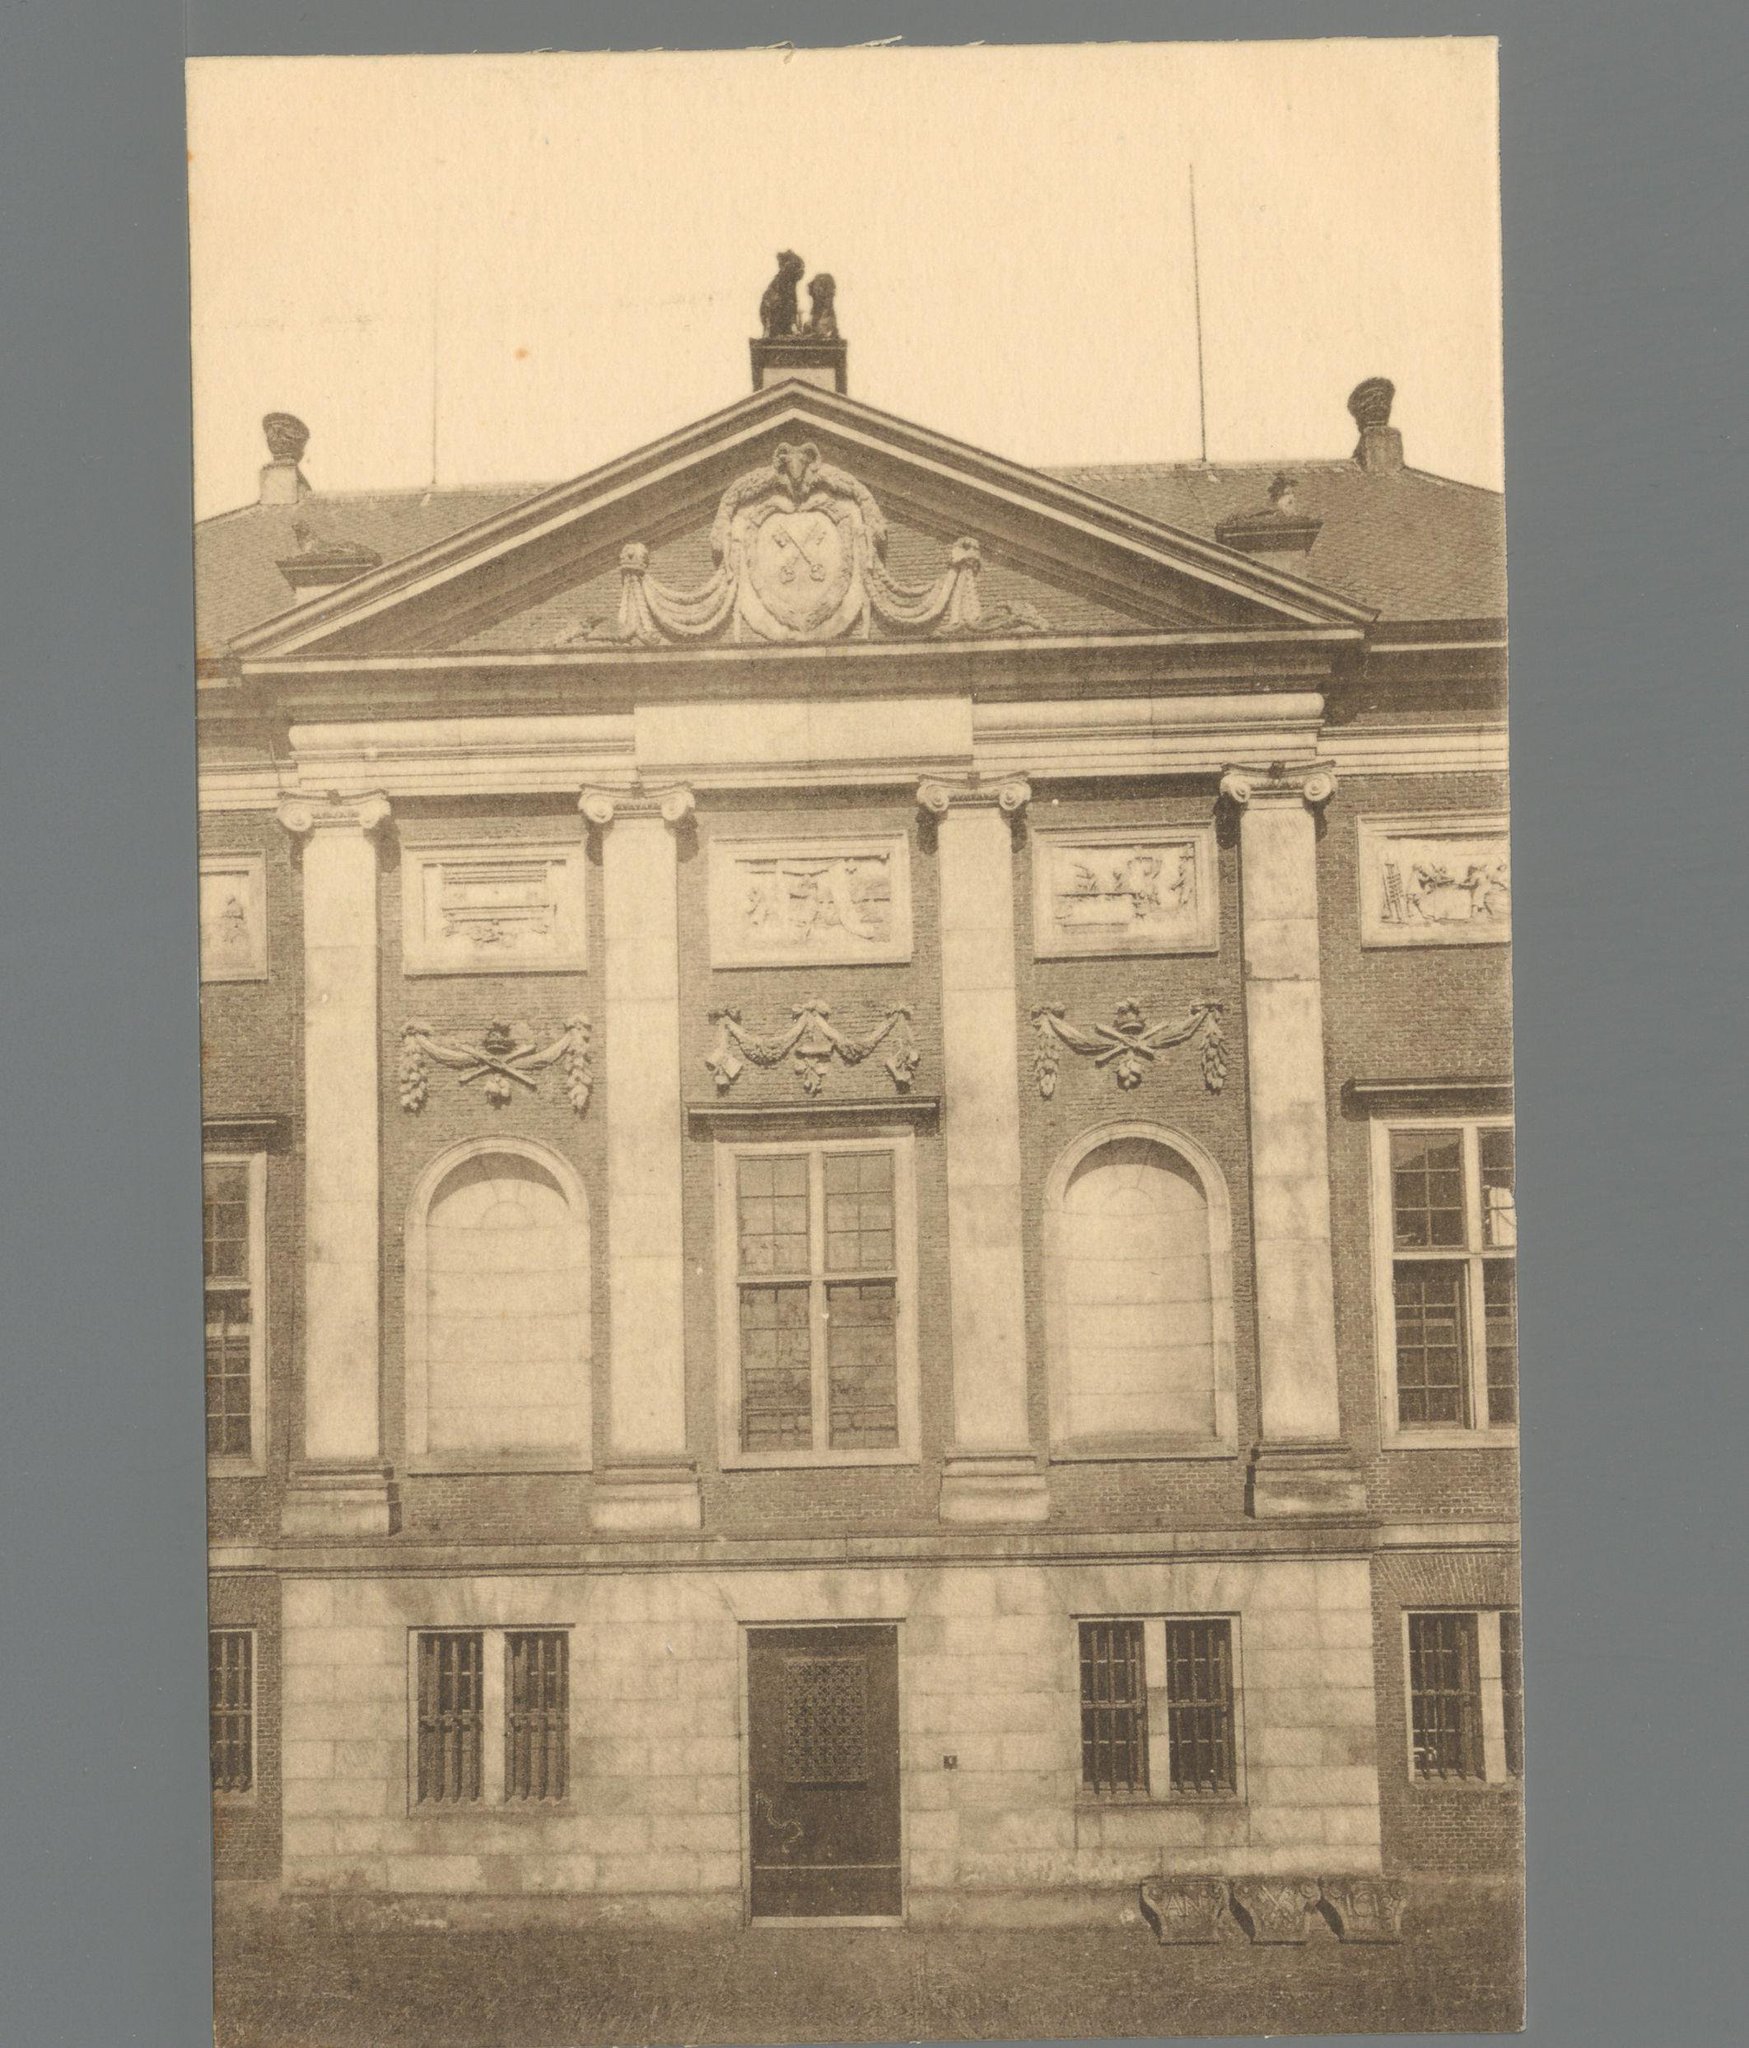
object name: photomechanical print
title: Leiden. Lakenhal, middenfront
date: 1905-1930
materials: cardboard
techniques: photograph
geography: leiden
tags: permanent exhibition, museum